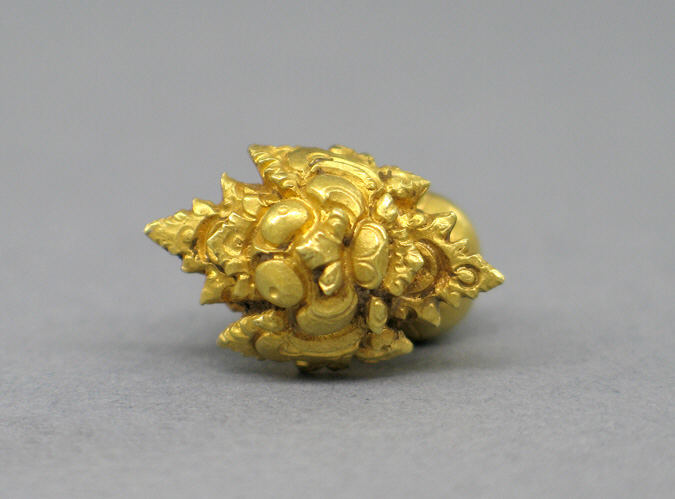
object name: ear ornament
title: Pair of Ear Ornaments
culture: indonesian, javanese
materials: gold